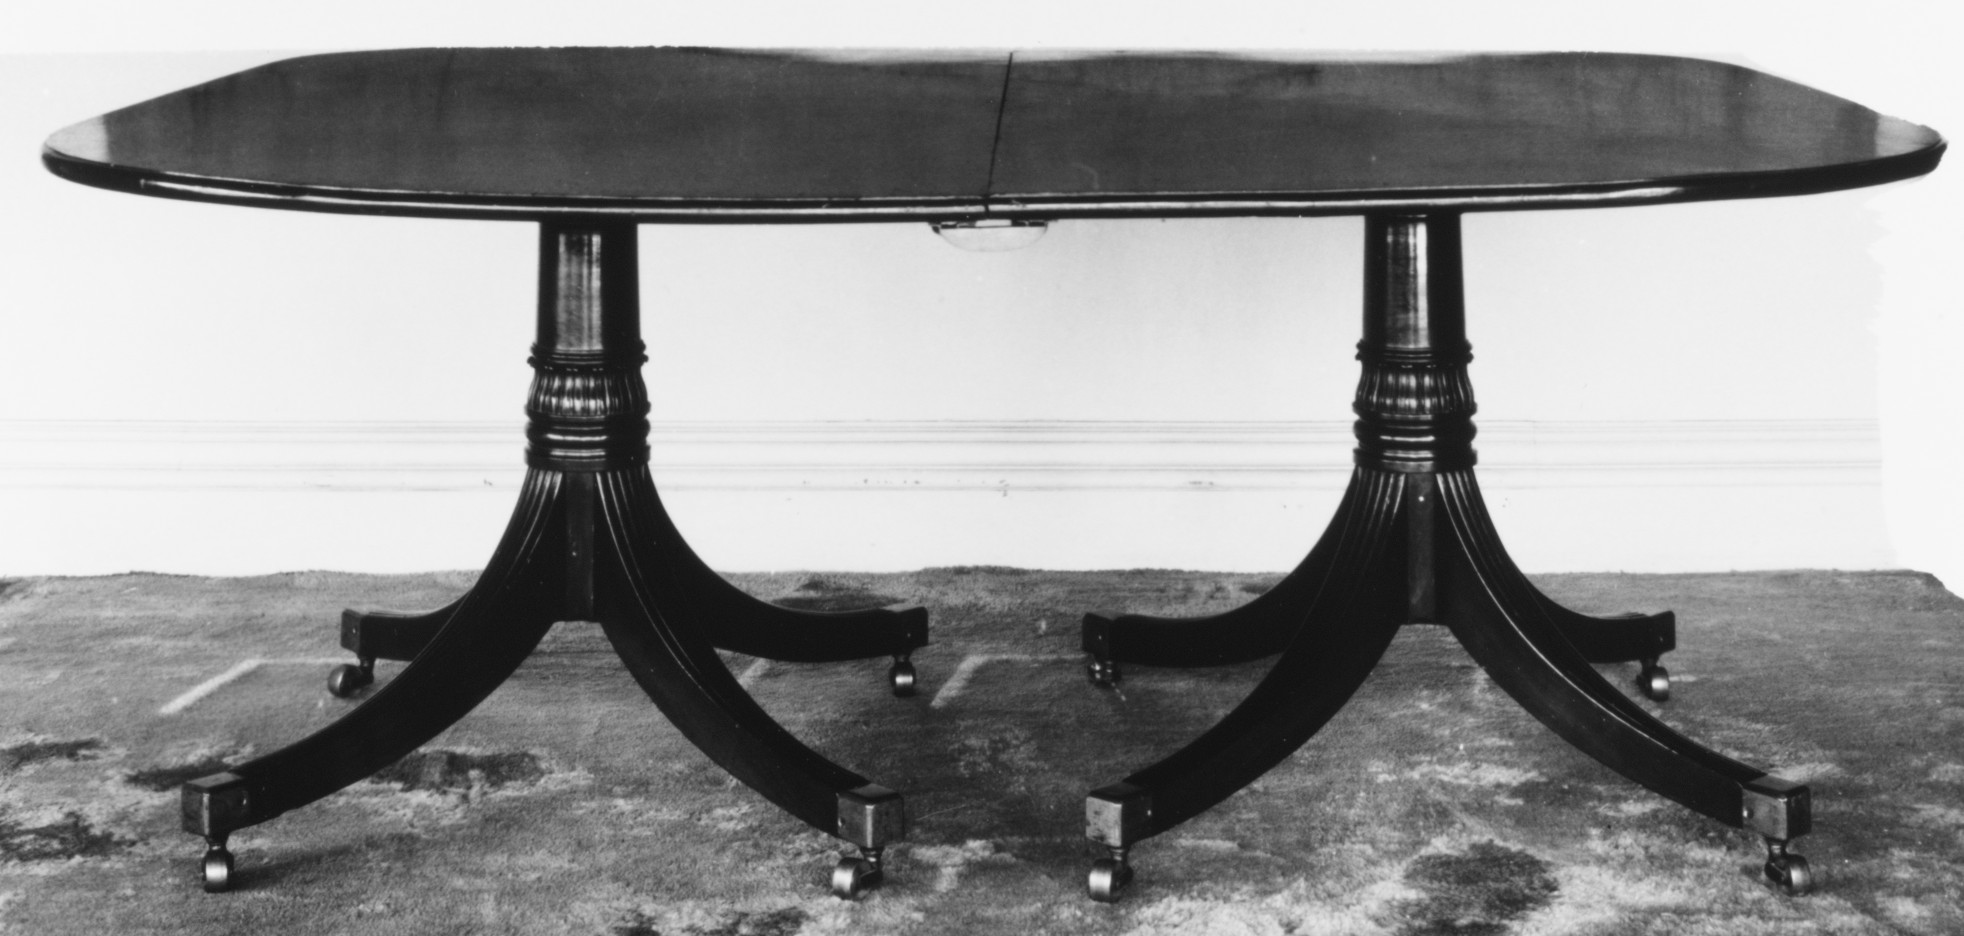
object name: table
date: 1840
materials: brass, wood